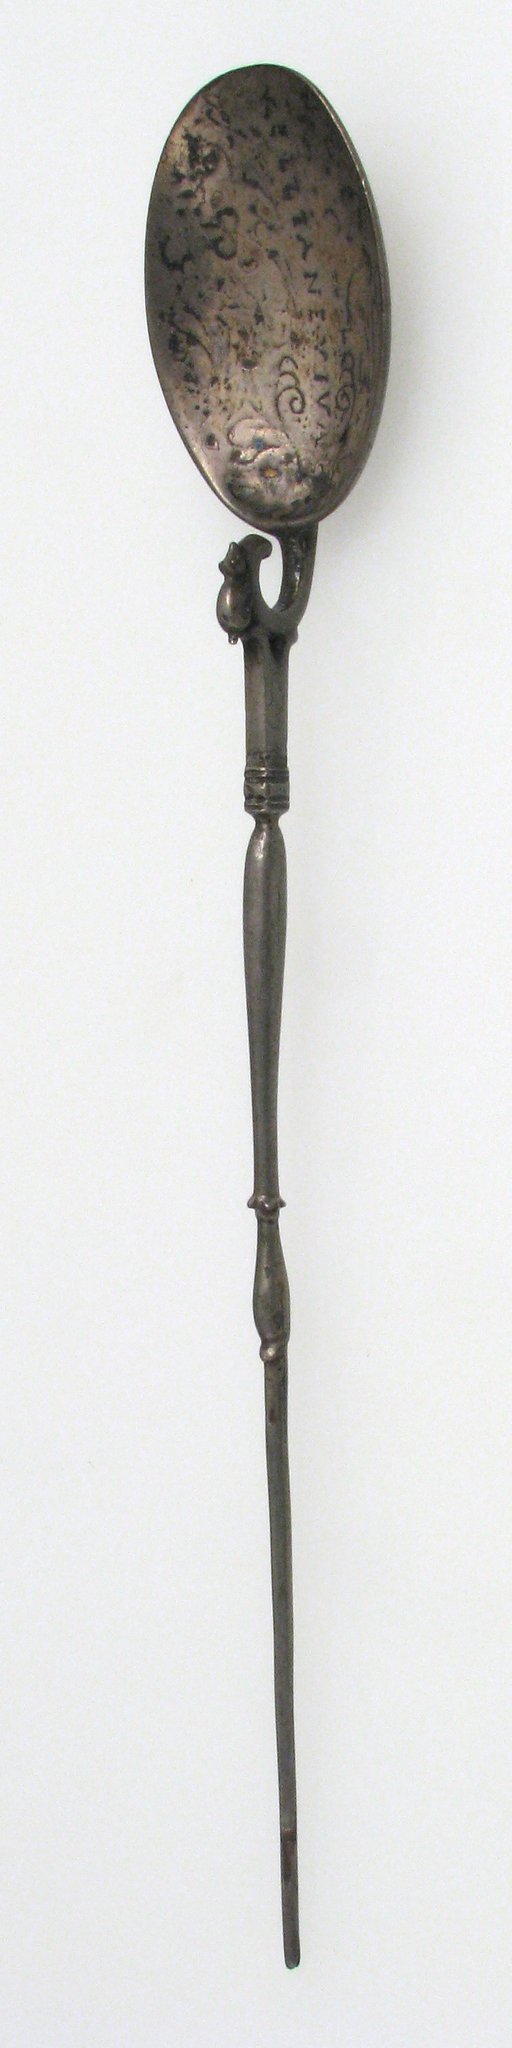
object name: spoon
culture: roman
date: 101-400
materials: silver